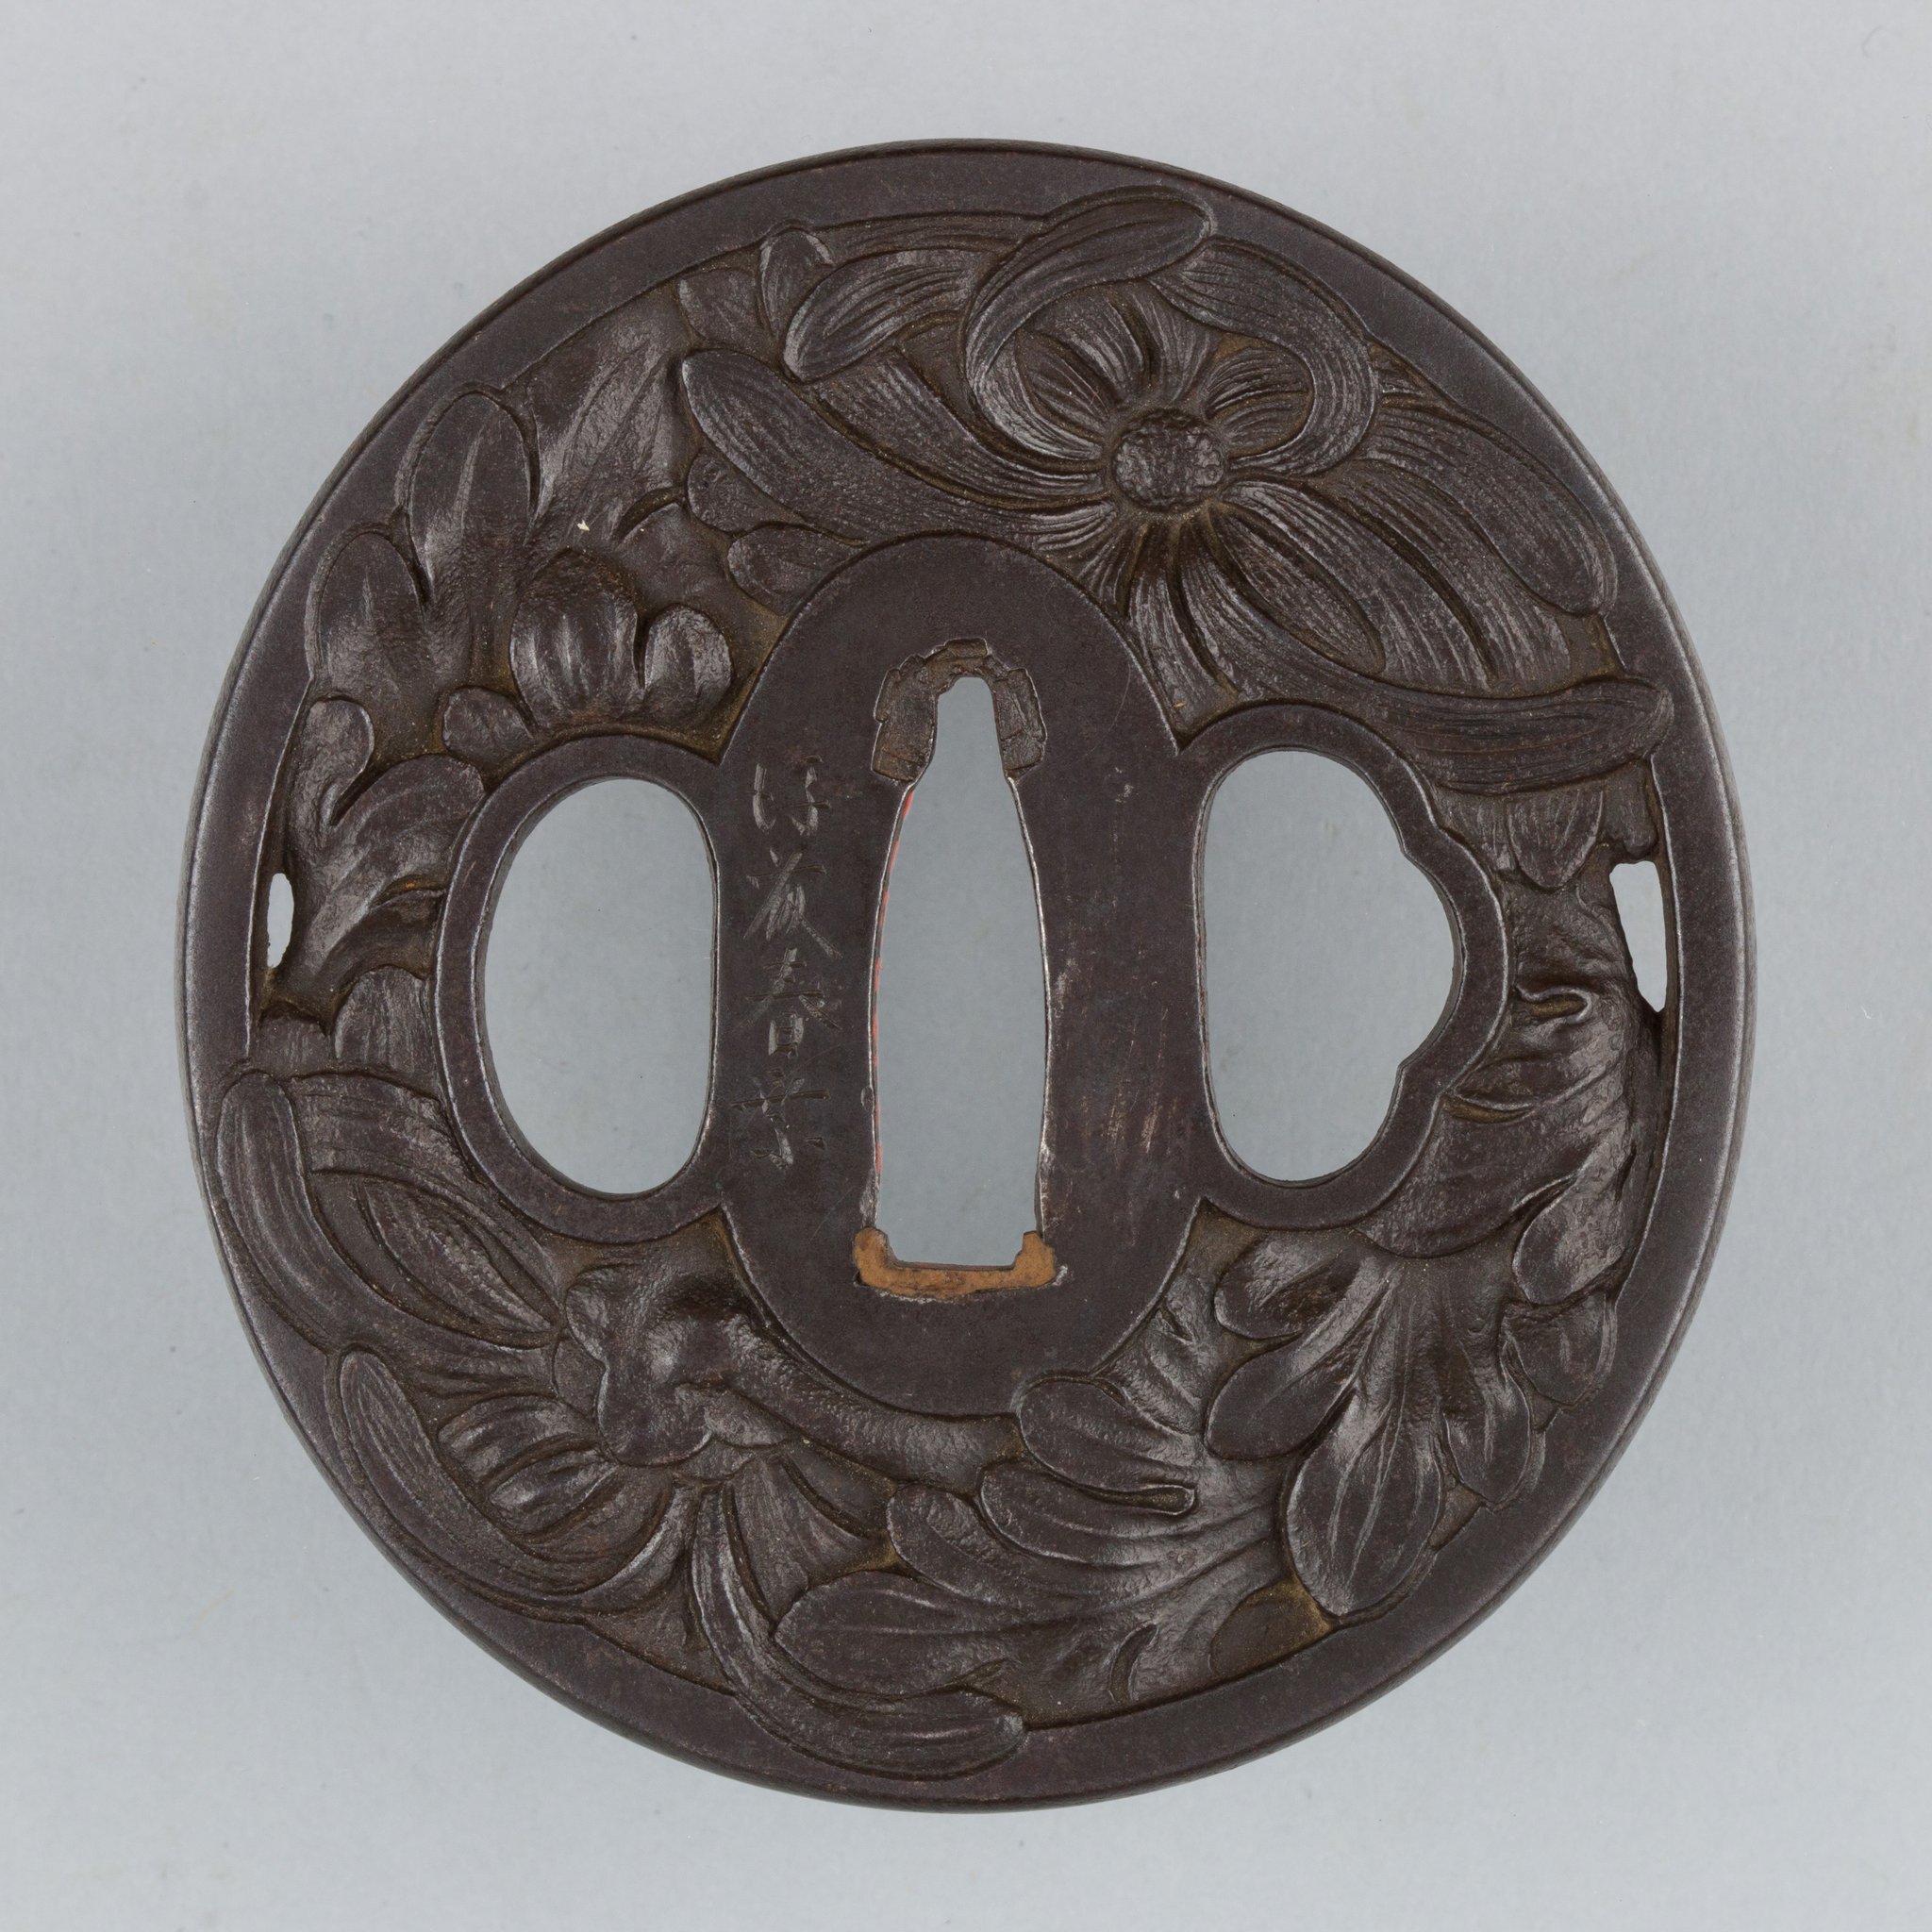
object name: sword guard tsuba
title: Sword Guard (Tsuba)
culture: japanese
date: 1701-1800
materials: copper, iron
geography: japan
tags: flowers